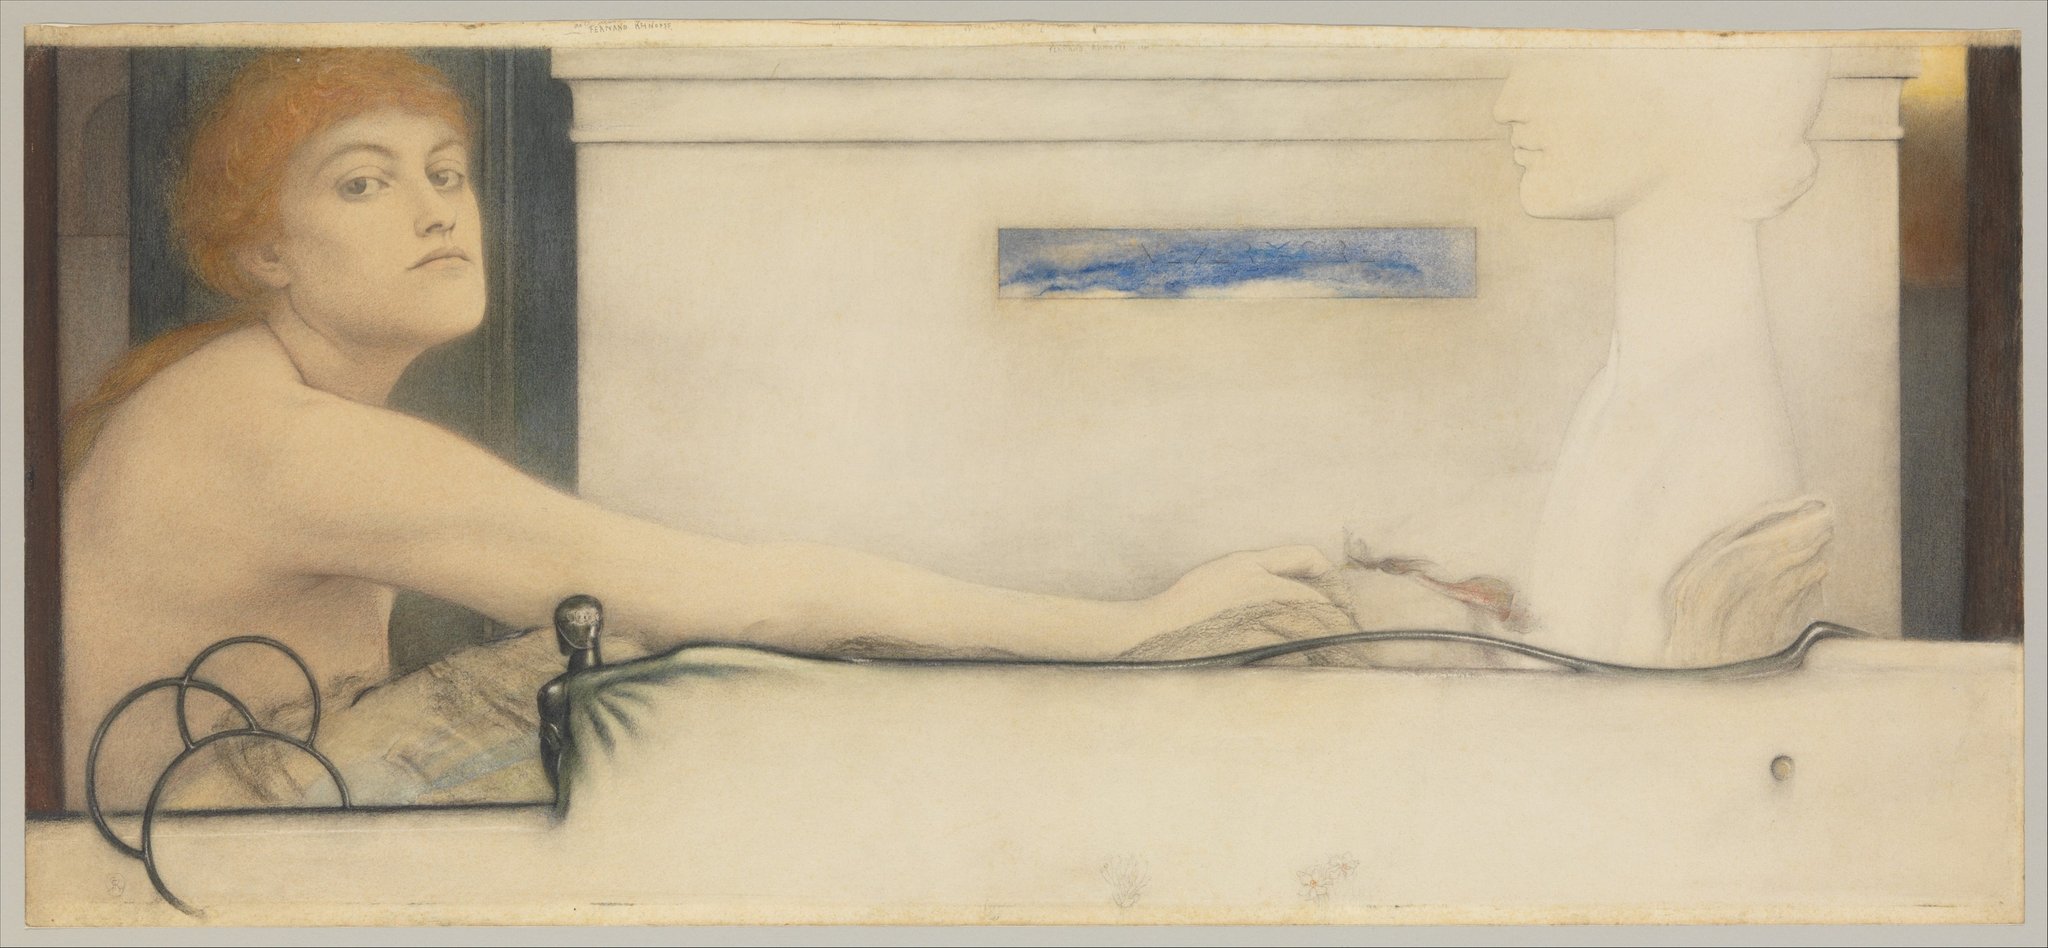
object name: drawing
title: The Offering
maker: fernand khnopff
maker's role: artist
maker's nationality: belgian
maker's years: 1858-1921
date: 1891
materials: chalk, graphite, paper, pastel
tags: female nudes